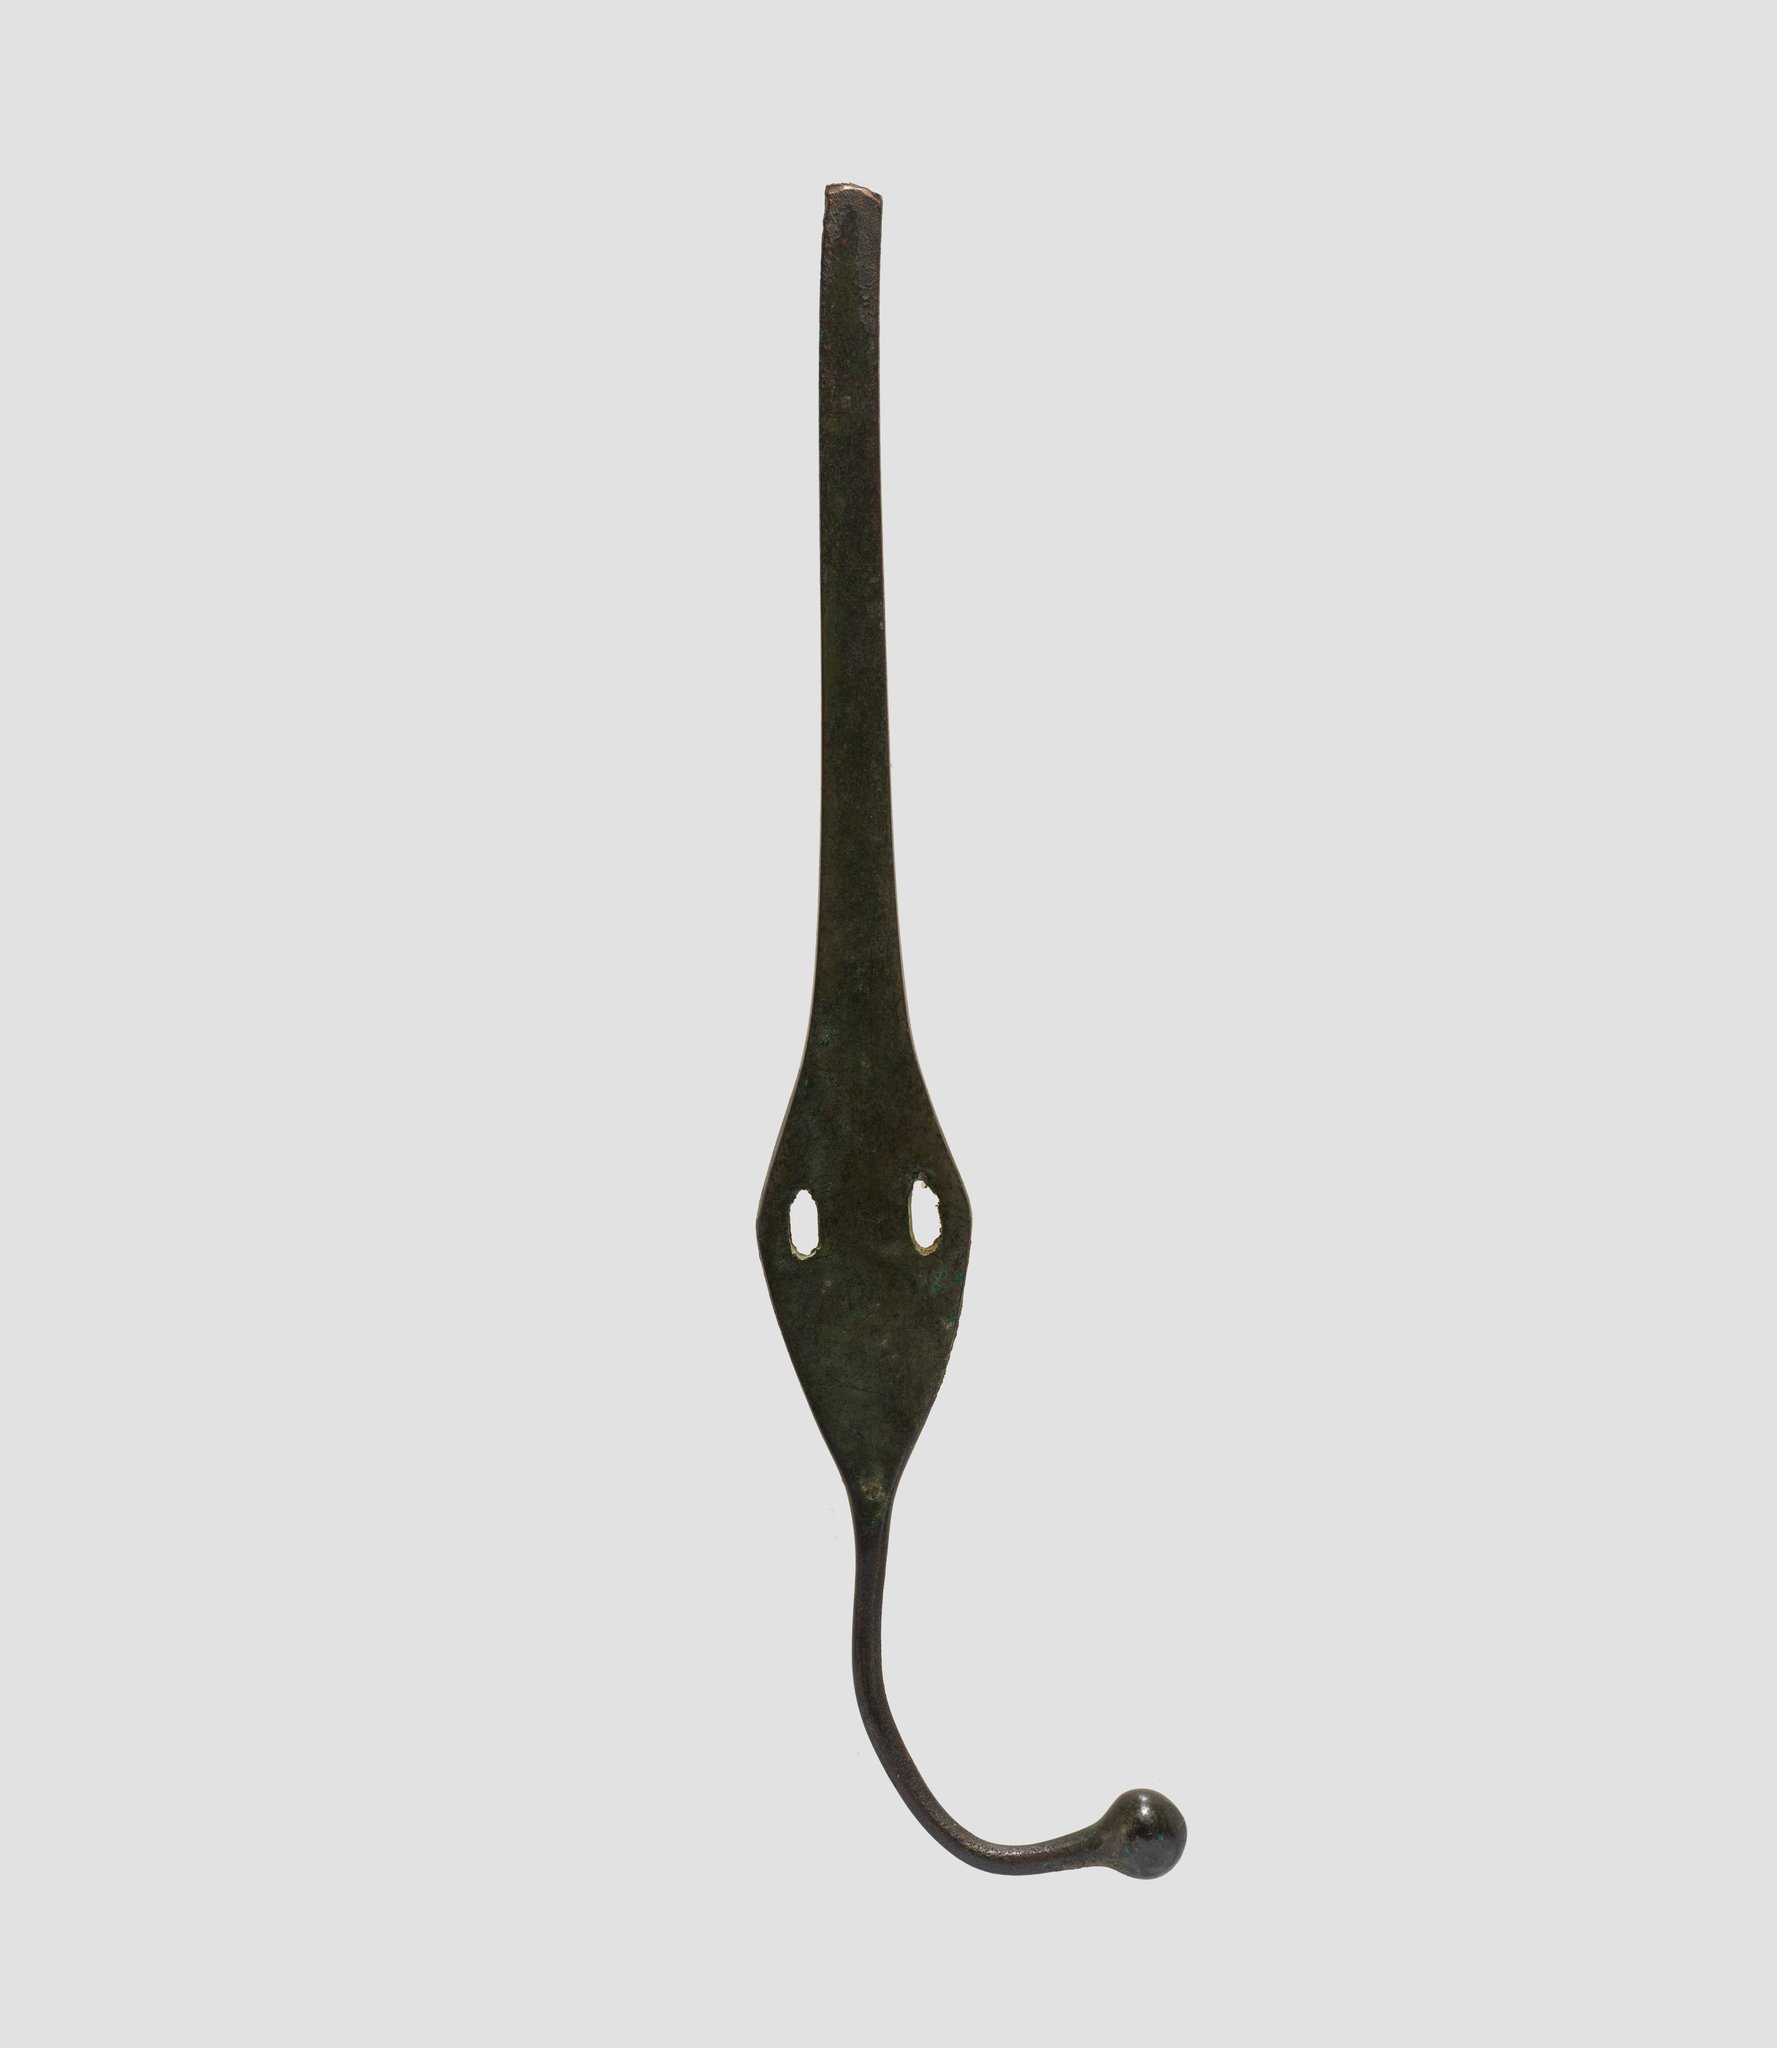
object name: spearhead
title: Spearhead with bent tang and slotted blade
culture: hattian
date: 2300-2000 BCE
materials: bronze, copper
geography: central anatolia